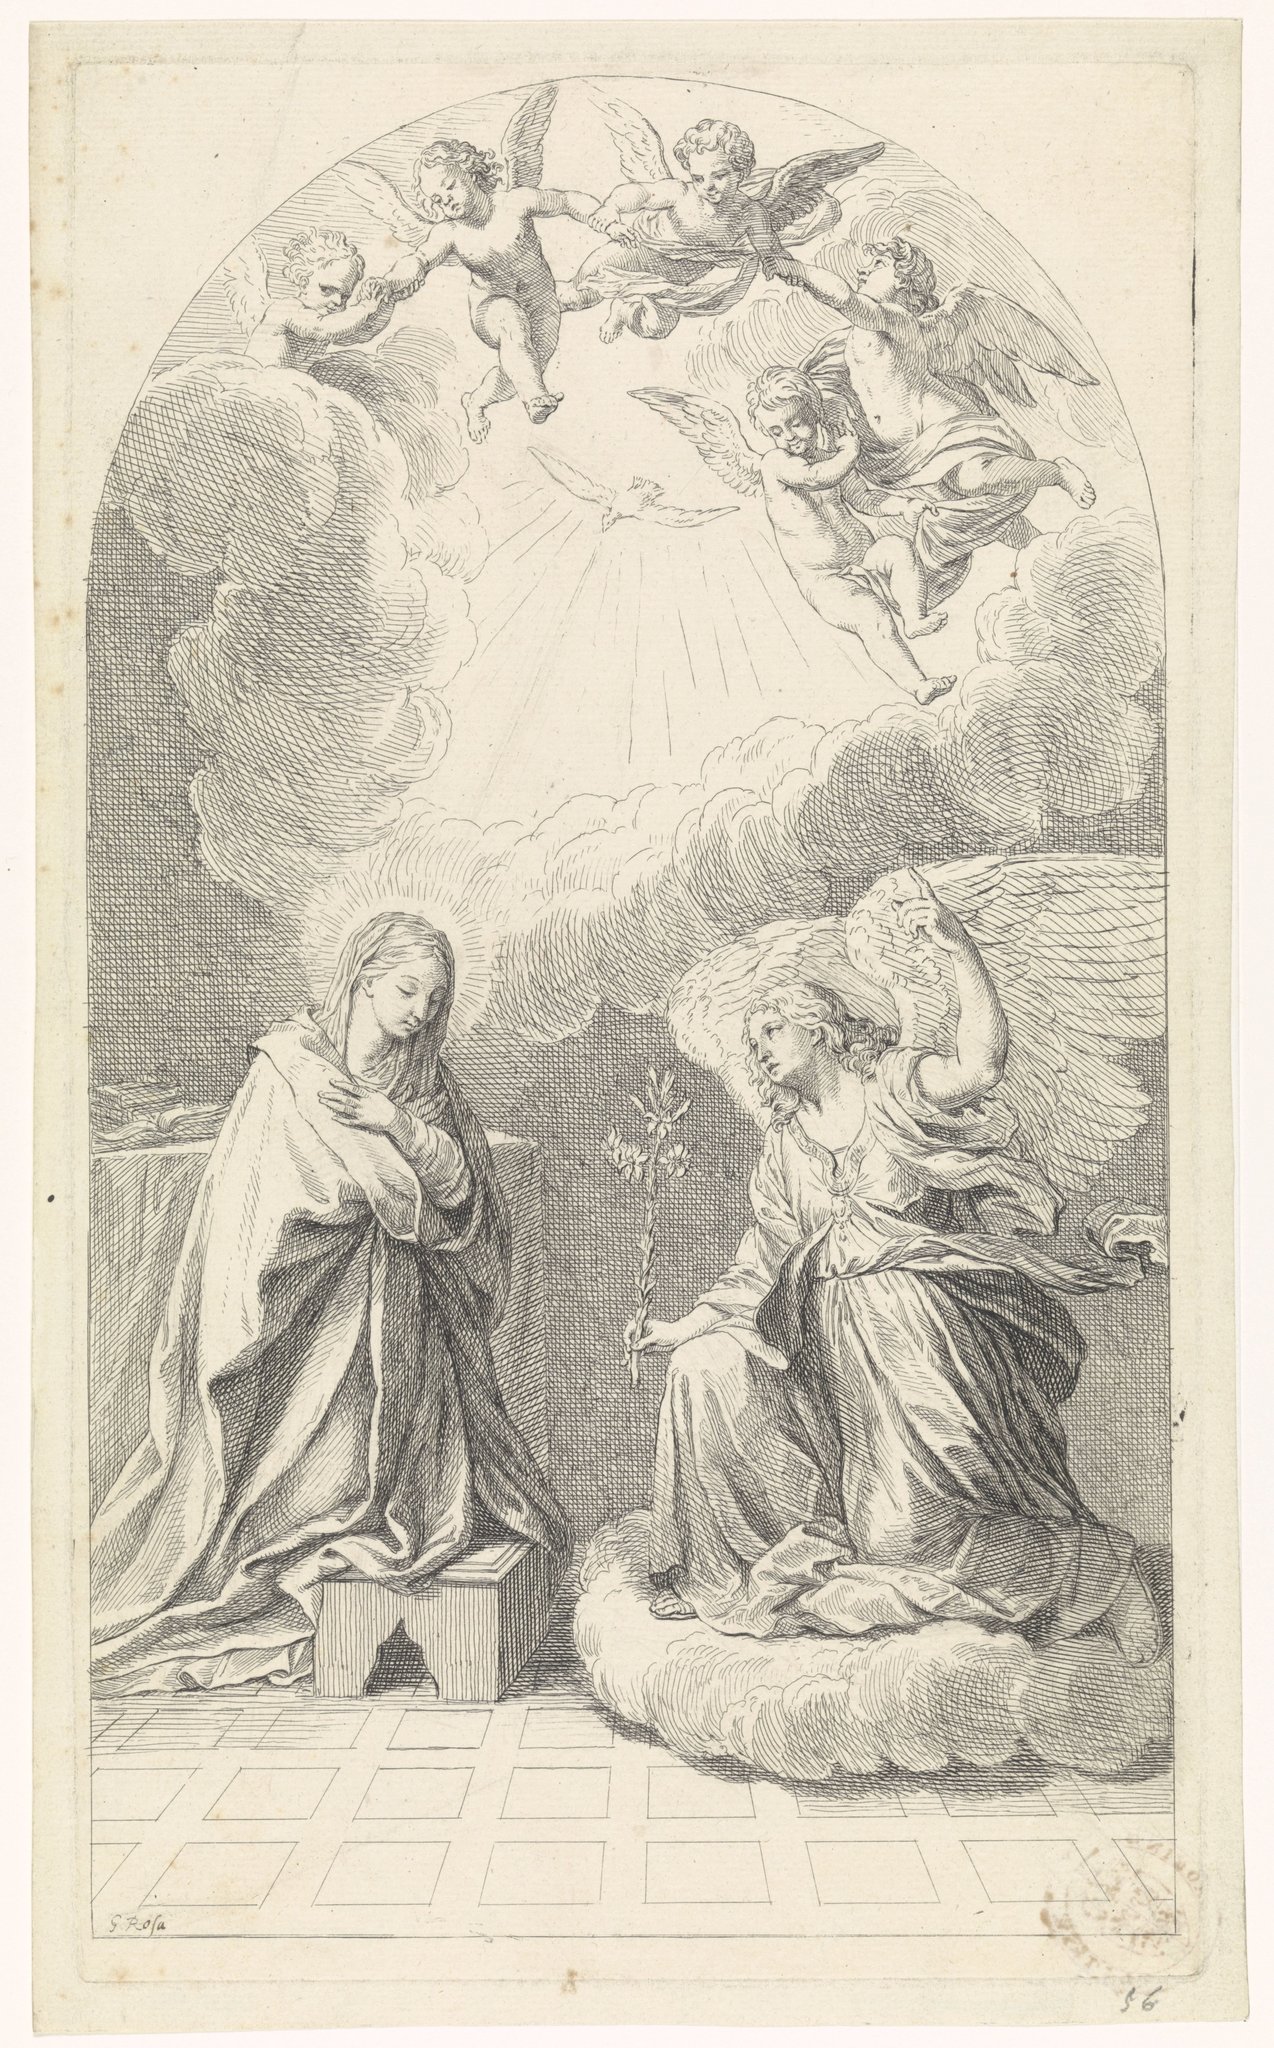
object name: print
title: Annunciatie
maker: bernard picart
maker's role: draughtsman, print maker, publisher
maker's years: 1673-1733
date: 1683-1733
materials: paper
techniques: etching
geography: amsterdam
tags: the annunciation: mary kneeling - aa - mary to the left, the angel to the right, holy ghost represented as a dove (in flames)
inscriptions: collector's mark: Lugt 240, inscription: ‘S. Rosa’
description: Definitieve genummerde staat van deze prent opgenomen in: Impostures innocentes, ou recueil d'estampes d'apres divers peintres (...) par Bernard Picart (...) avec son elogue historique et le catalogue de ses ouvrages. Amsterdam: weduwe Bernard Picart, 1734.